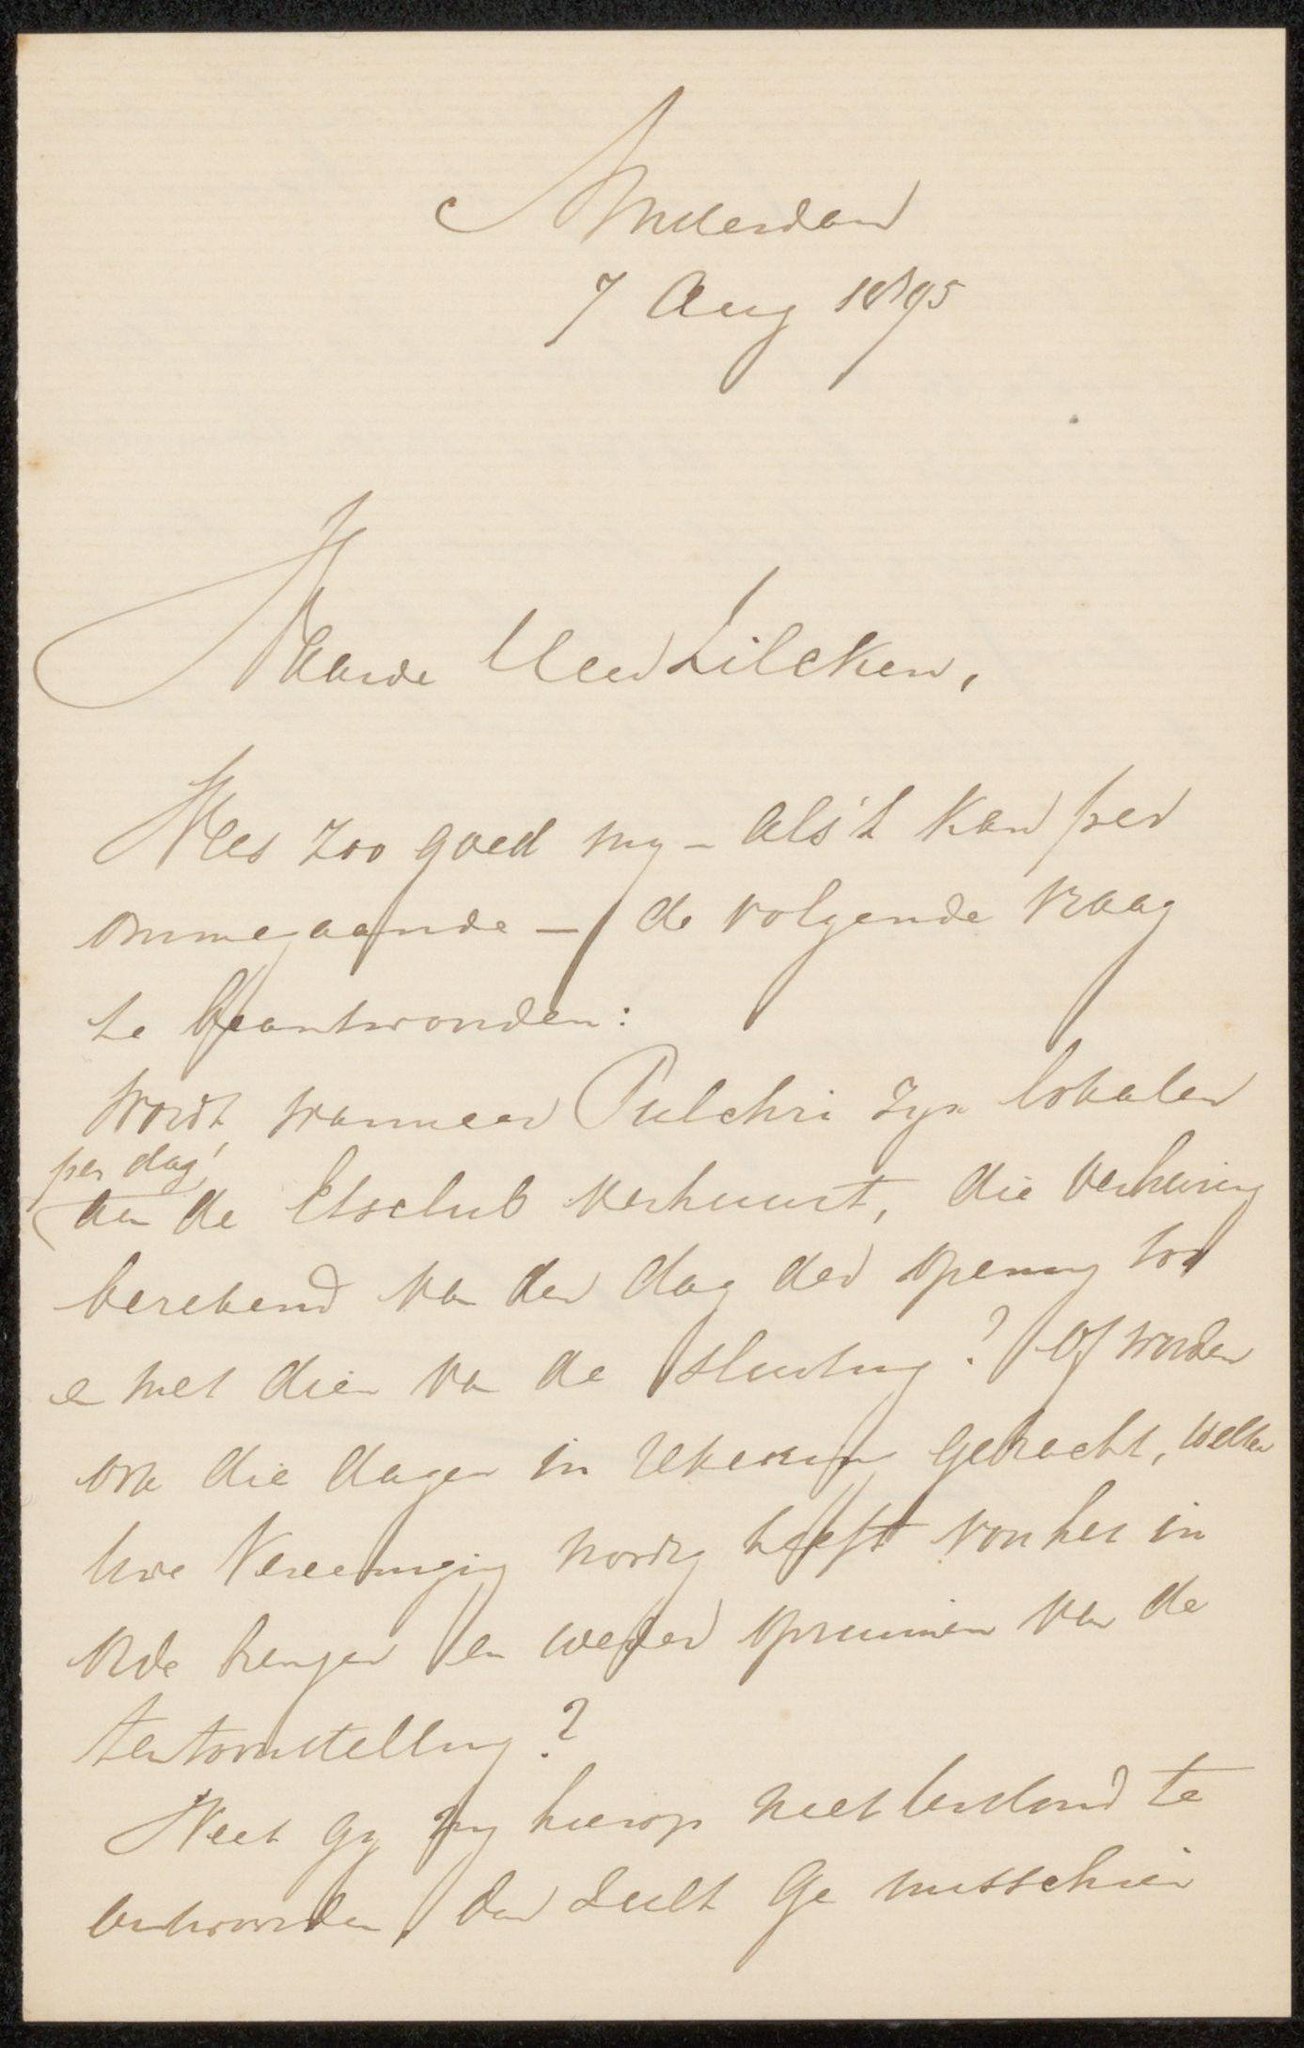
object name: letter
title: Brief aan Philip Zilcken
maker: jacob nicolaas van hall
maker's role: politician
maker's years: 1840-1918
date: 1895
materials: ink, paper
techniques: pen, writing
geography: amsterdam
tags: the hague, painter, philip zilcken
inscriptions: collector's mark: ‘RPK’